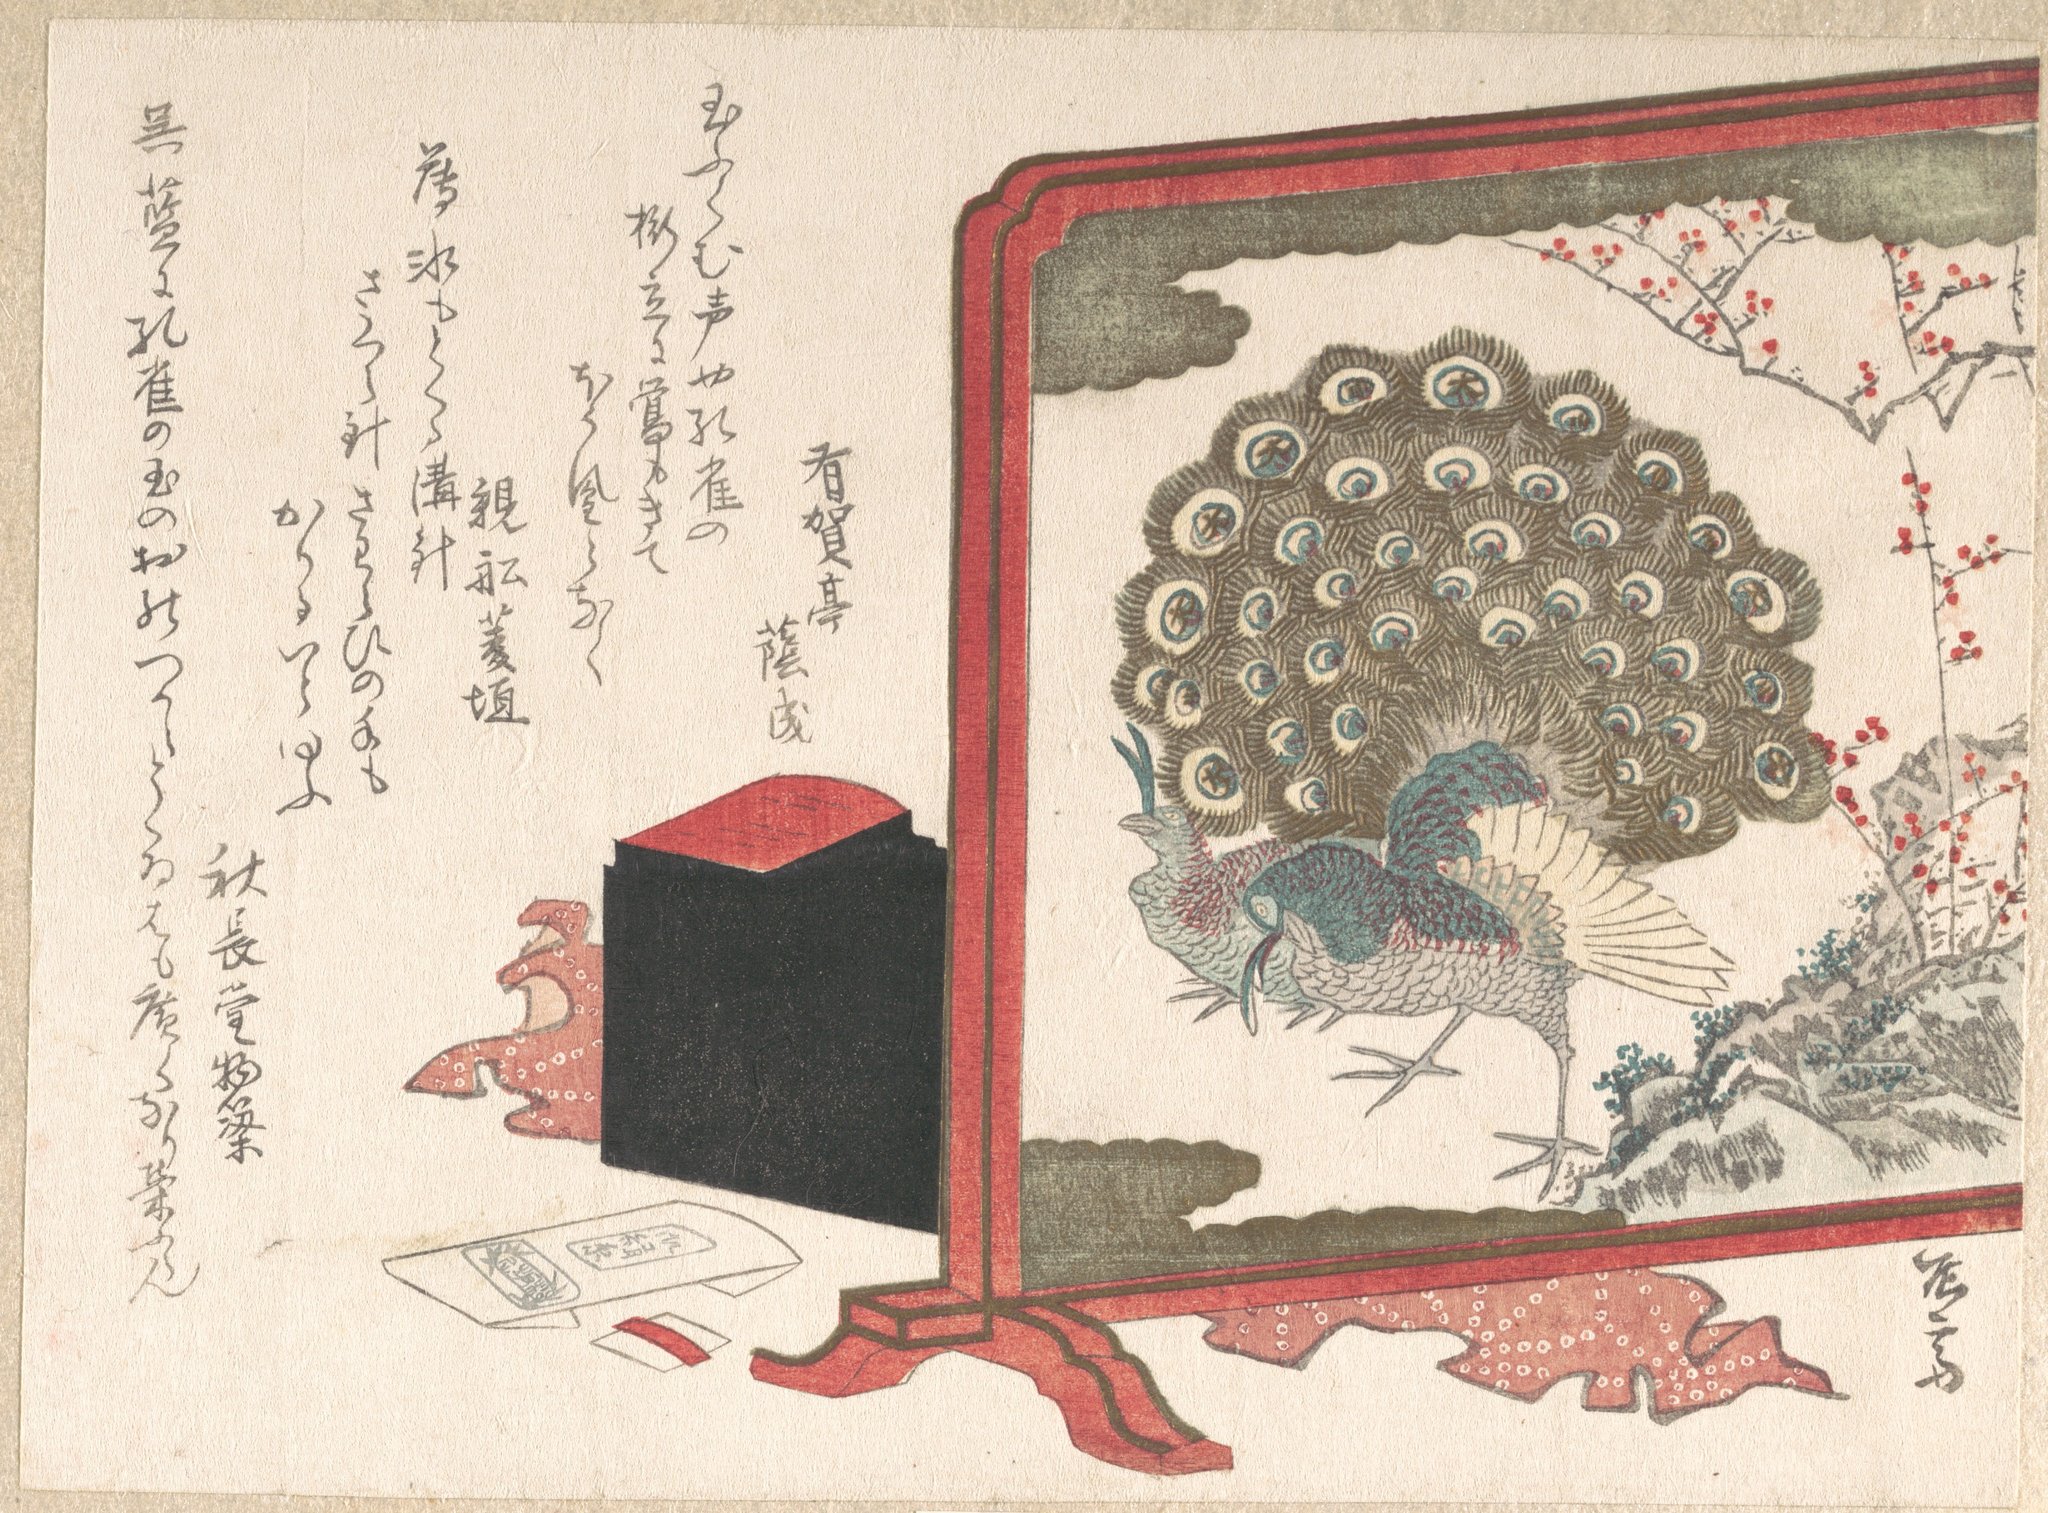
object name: woodblock print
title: Screen and Lady's Work-Box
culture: japanese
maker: ryūryūkyo shinsai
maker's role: artist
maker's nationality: japanese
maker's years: 1799-1823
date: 1801-1900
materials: ink, paper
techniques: surimono, woodblock print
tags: peacocks,screens